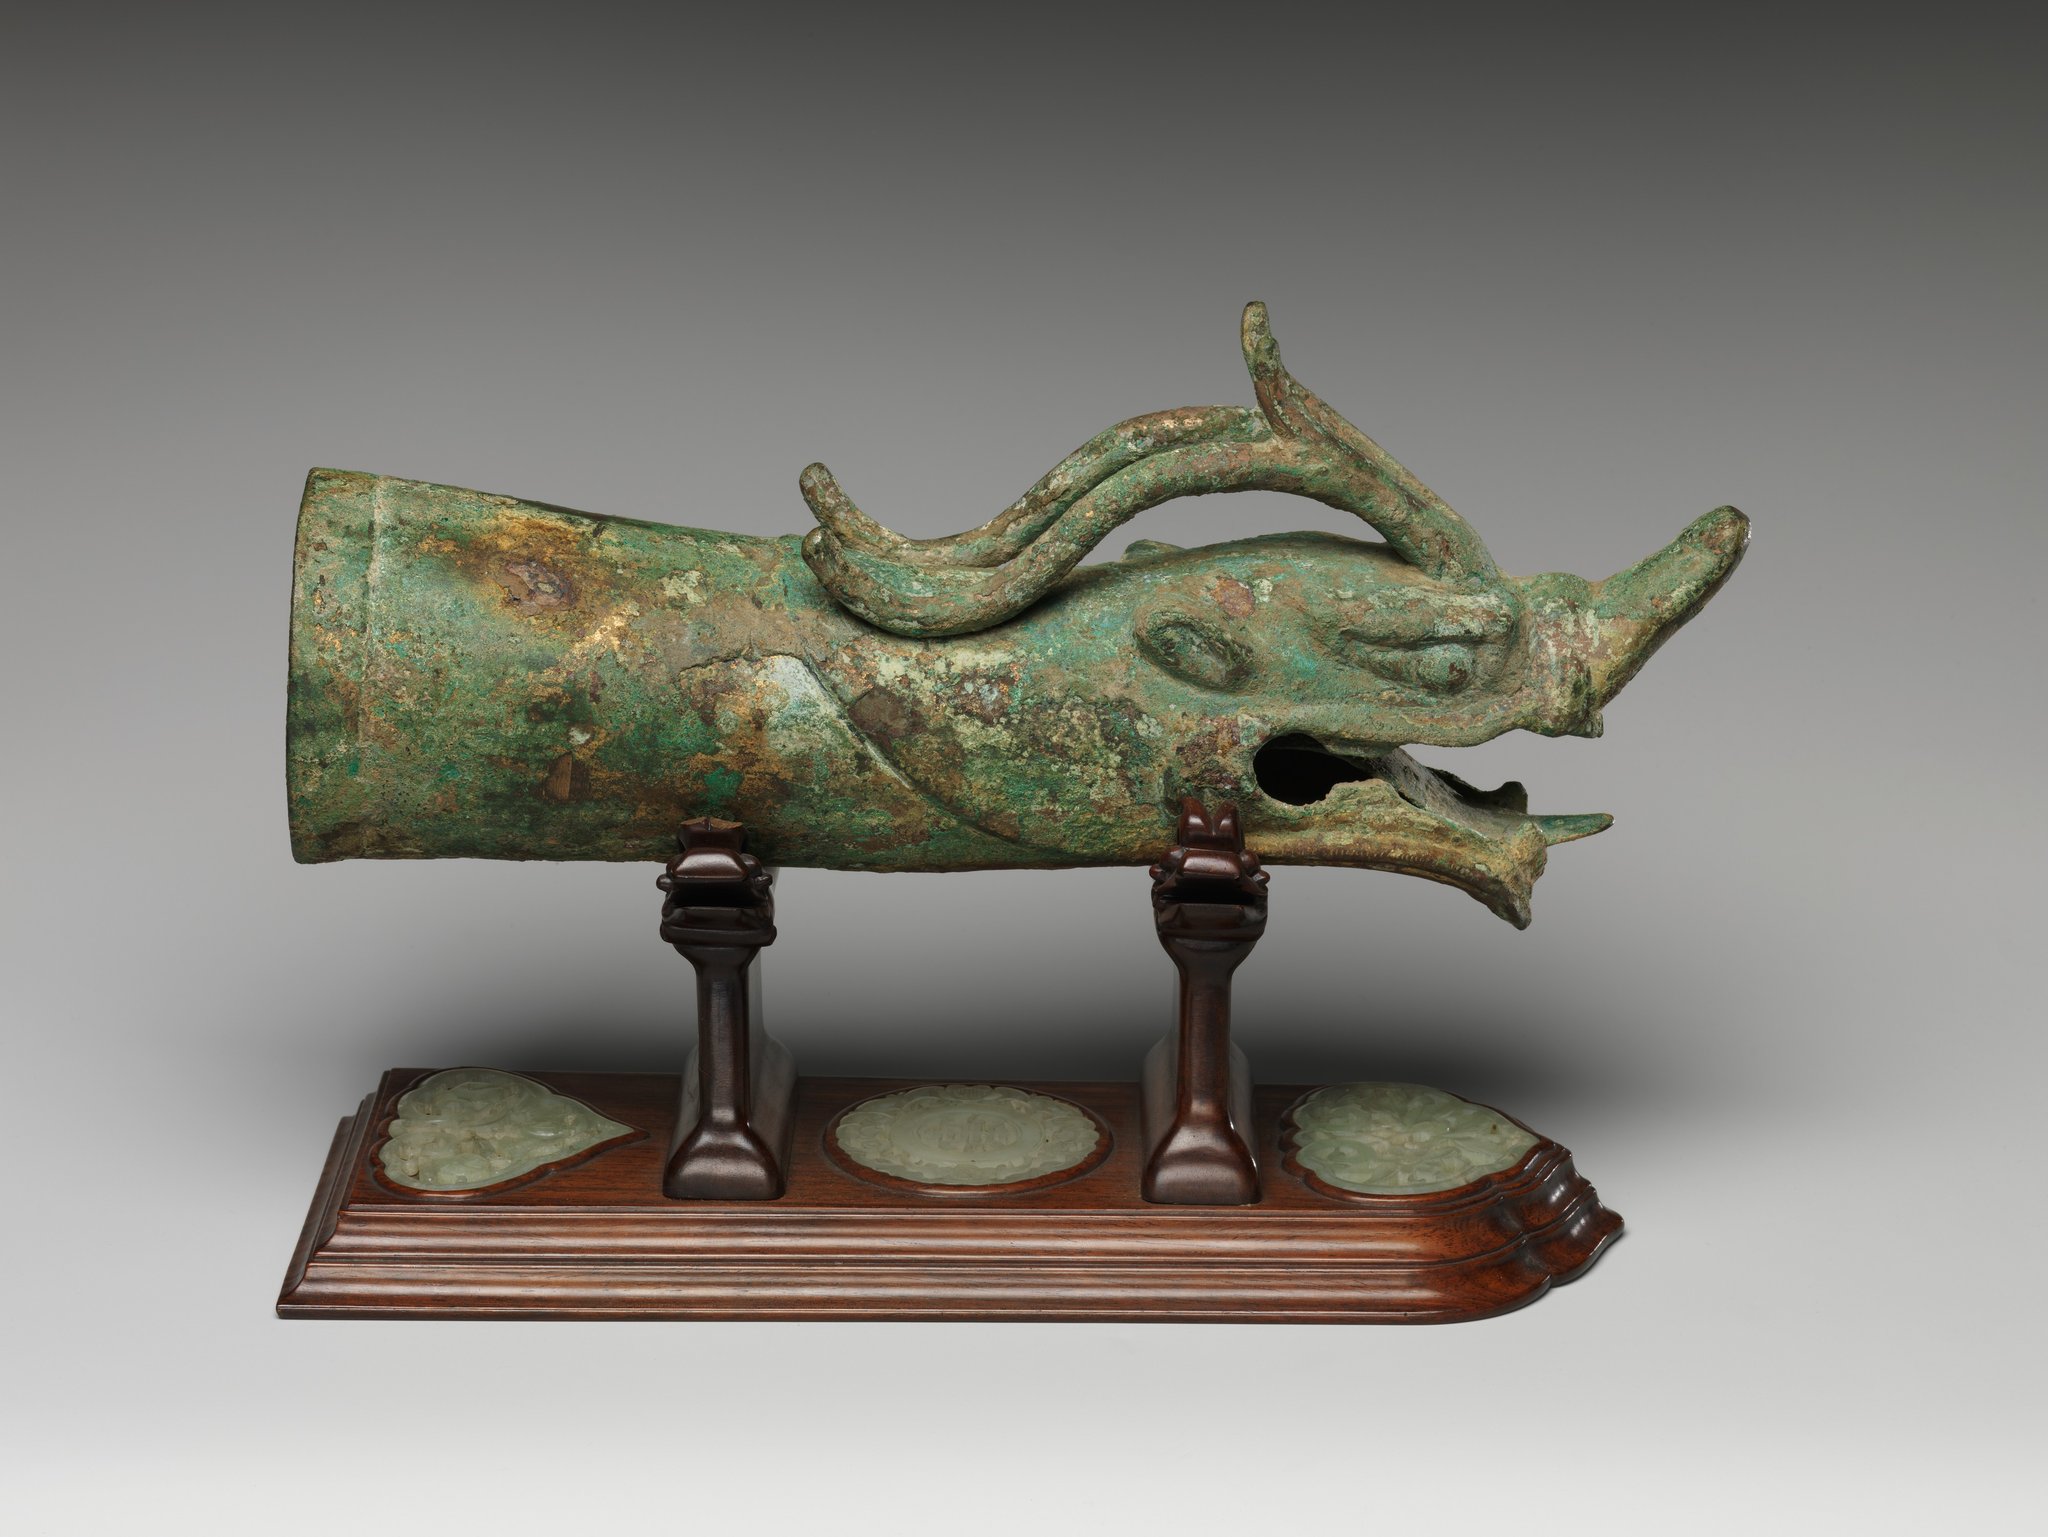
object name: finial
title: Finial in the shape of a dragon’s head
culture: chinese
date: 618-907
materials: gilt bronze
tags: dragons